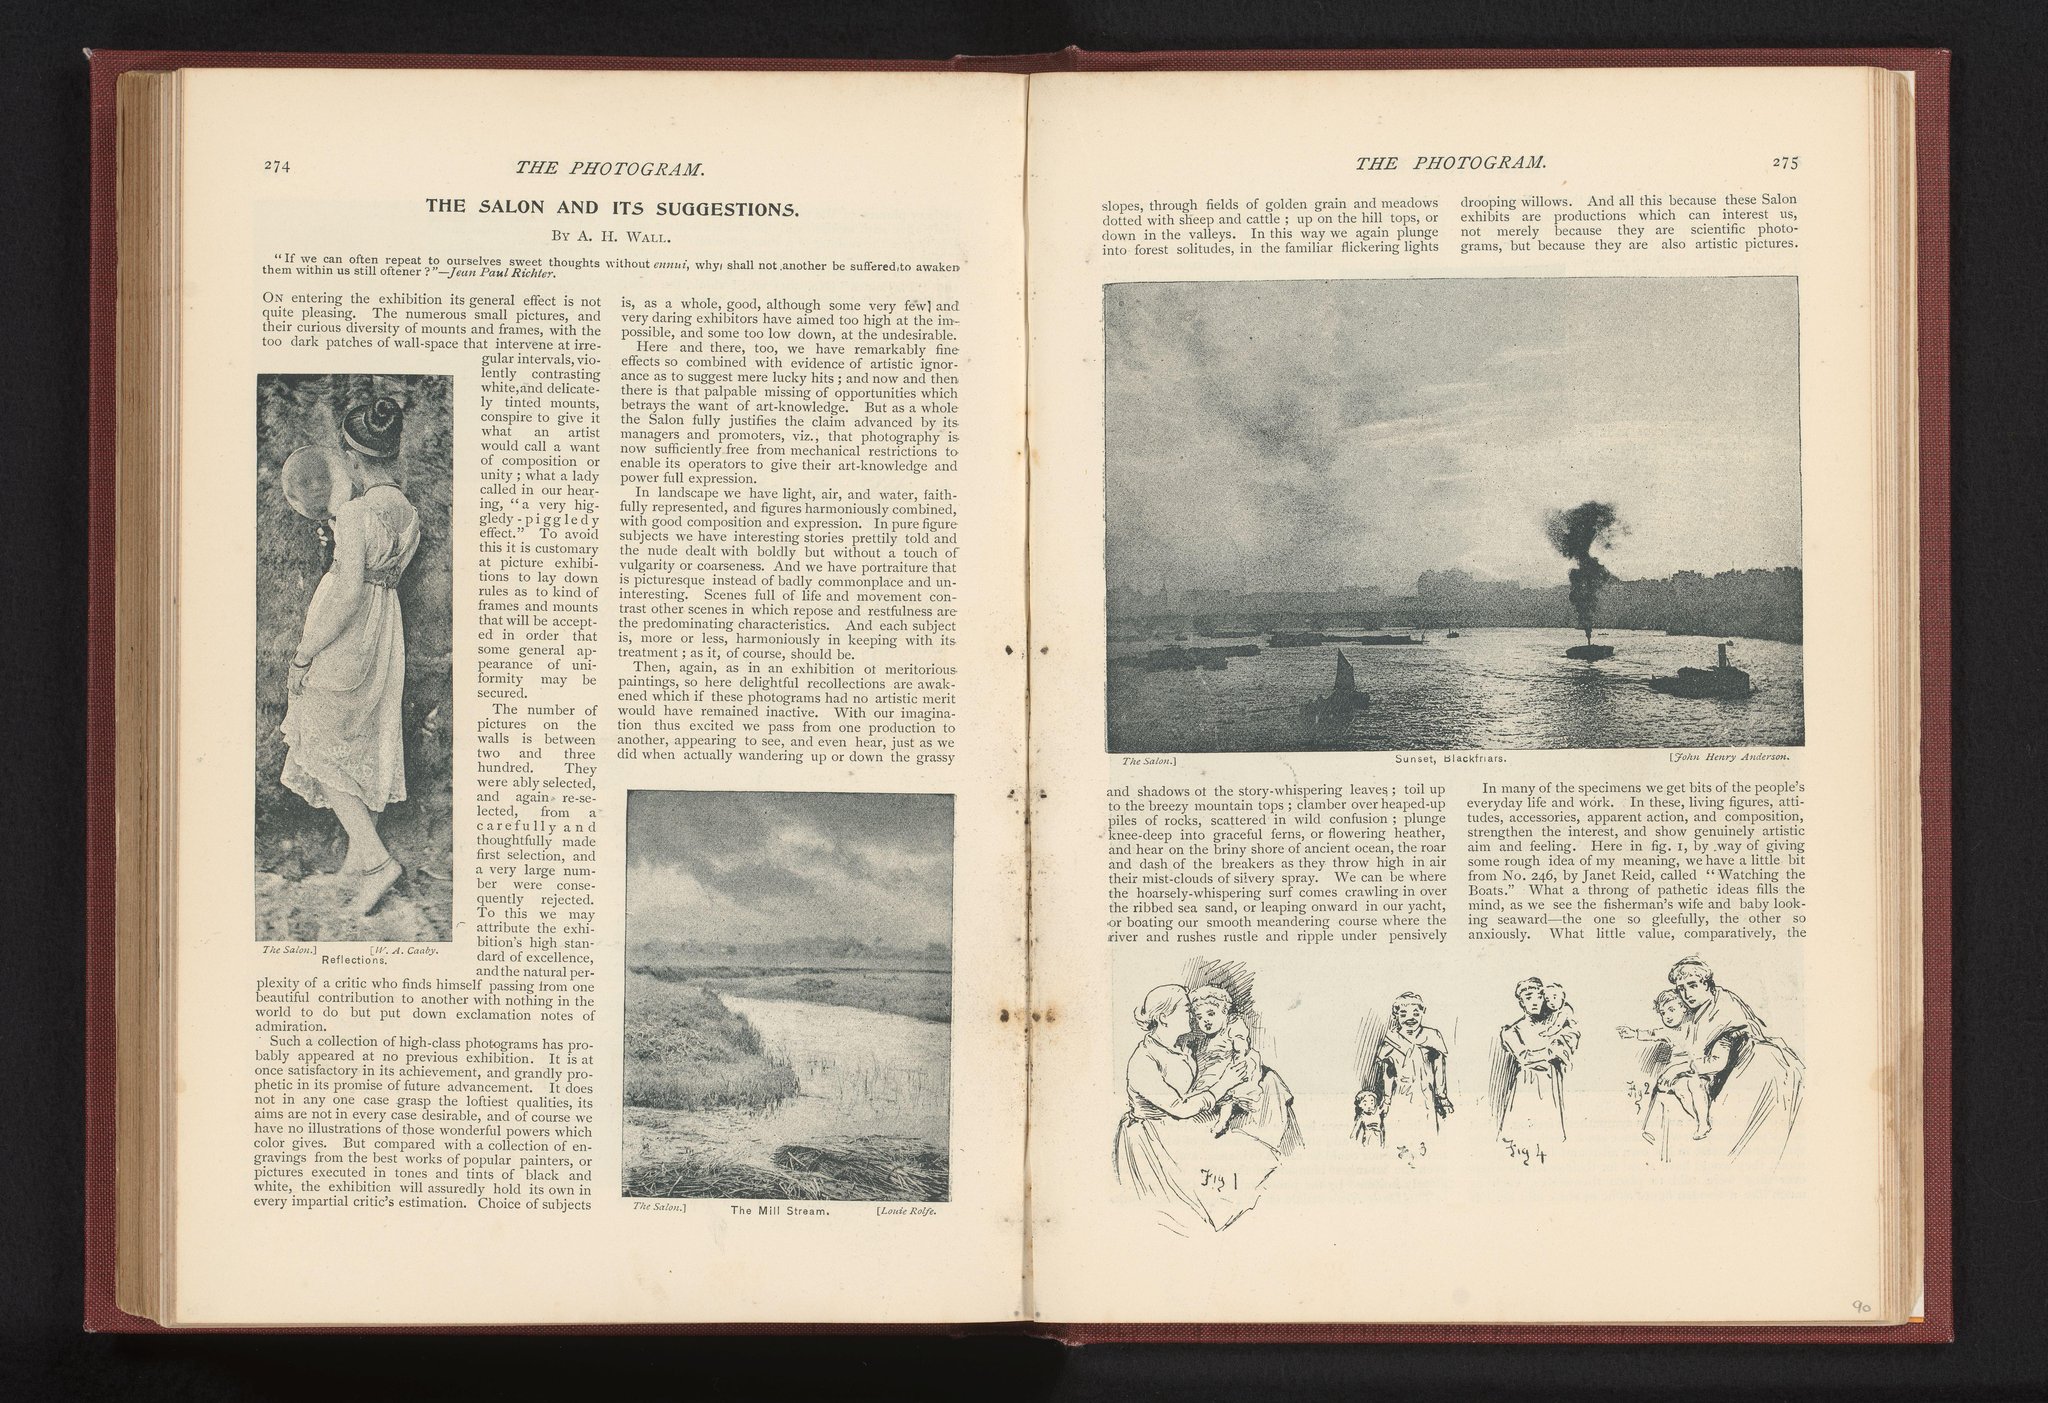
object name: page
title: Landschap met waterloop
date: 1889-1894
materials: paper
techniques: autotype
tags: landscapes with waters, waterscapes, seascapes (in the temperate zone)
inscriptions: inscription: ‘The Salon’